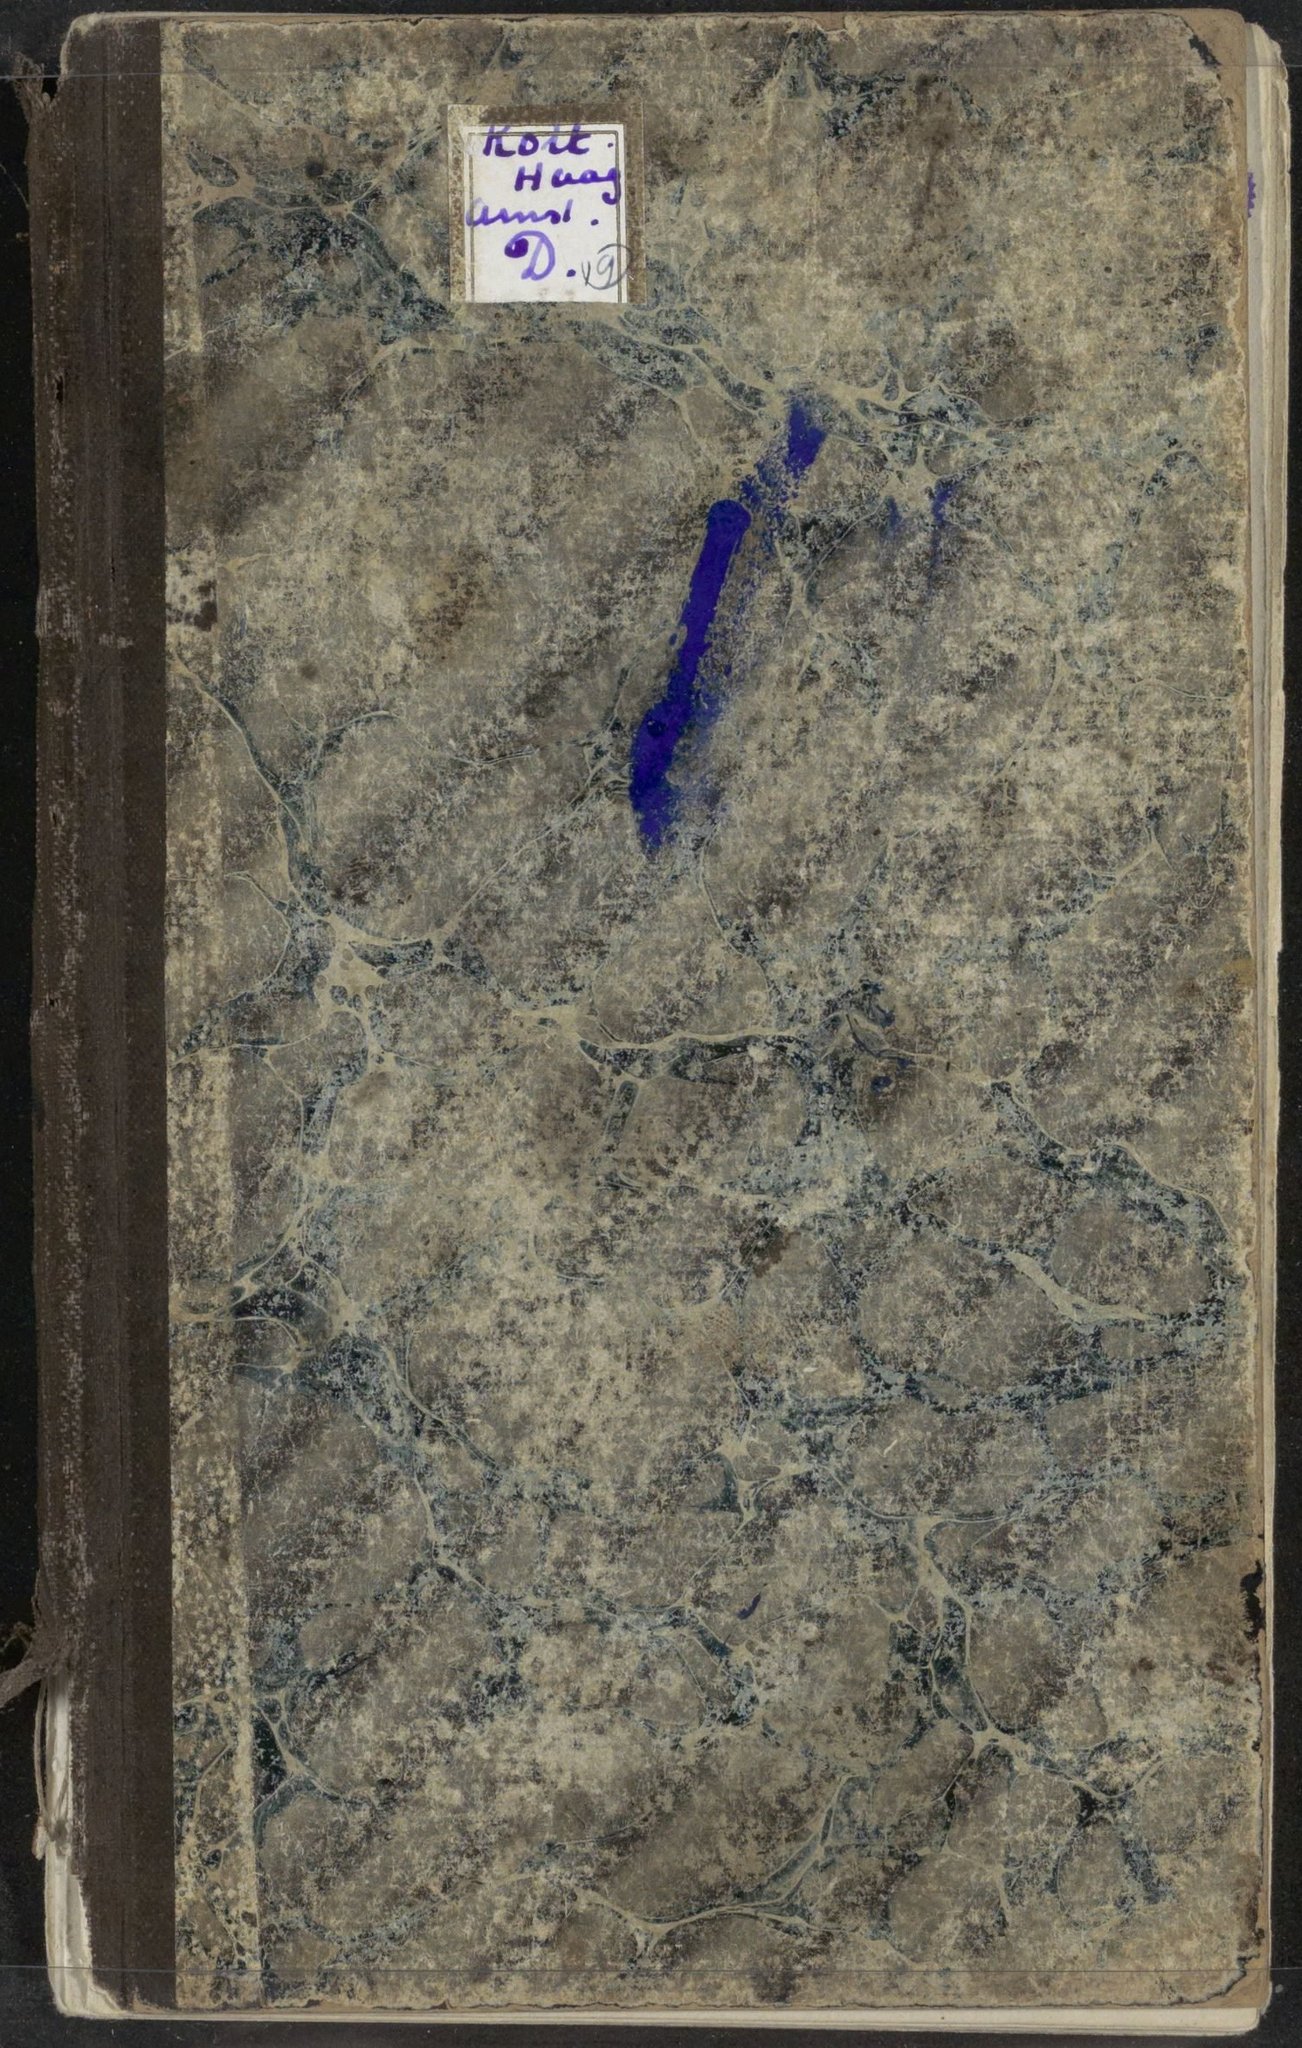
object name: sketchbook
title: Schetsboek met 10 bladen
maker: george hendrik breitner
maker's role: draughtsman, painter, print maker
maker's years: 1857-1923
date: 1880-1882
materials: cardboard, chalk, linen, paper, pencil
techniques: marbling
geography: the hague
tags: landscapes in the temperate zone, public road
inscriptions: collector's mark: Lugt 2228, annotation: ‘9 stuks/ geteekend/ Rotterdam/ Den Haag’, workshop stamp: Lugt 291d, annotation: ‘Rott./ Haag/ Amst./ D.’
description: Schetsboek bestaande uit 10 bladen met figuurstudies, landschappen en architectuurstudies.